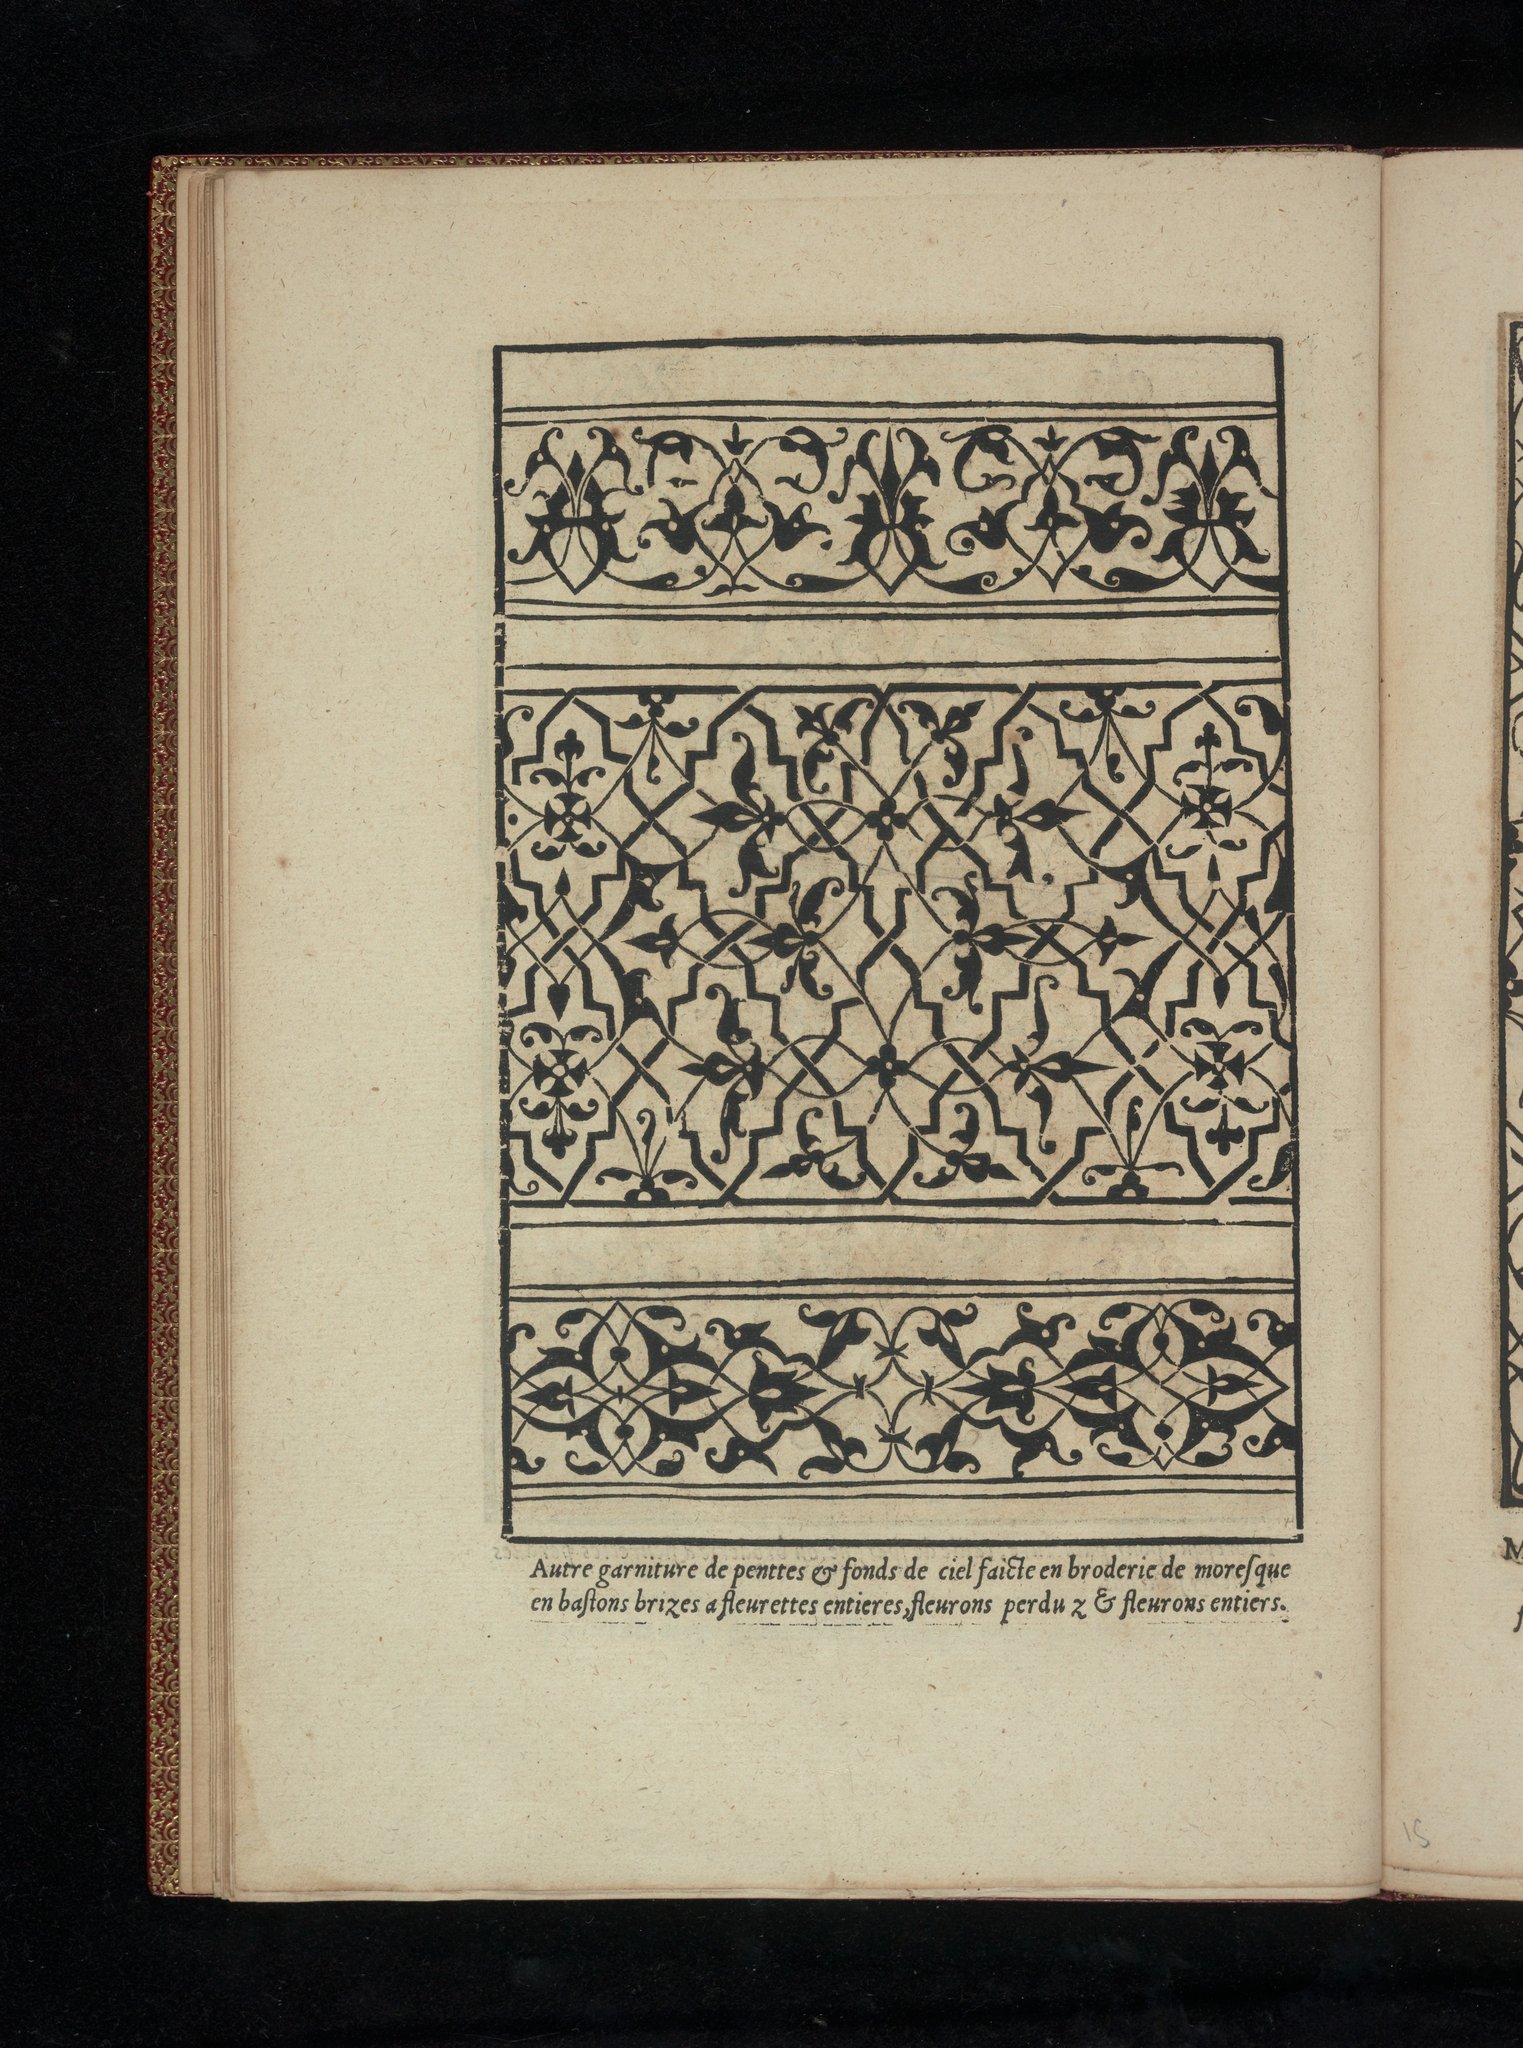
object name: book print ornament architecture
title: Livre de Moresques, page 8 (verso)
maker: francesco di pellegrino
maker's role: artist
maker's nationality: italian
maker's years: 1525-1552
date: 1546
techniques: woodcut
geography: france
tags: ornament